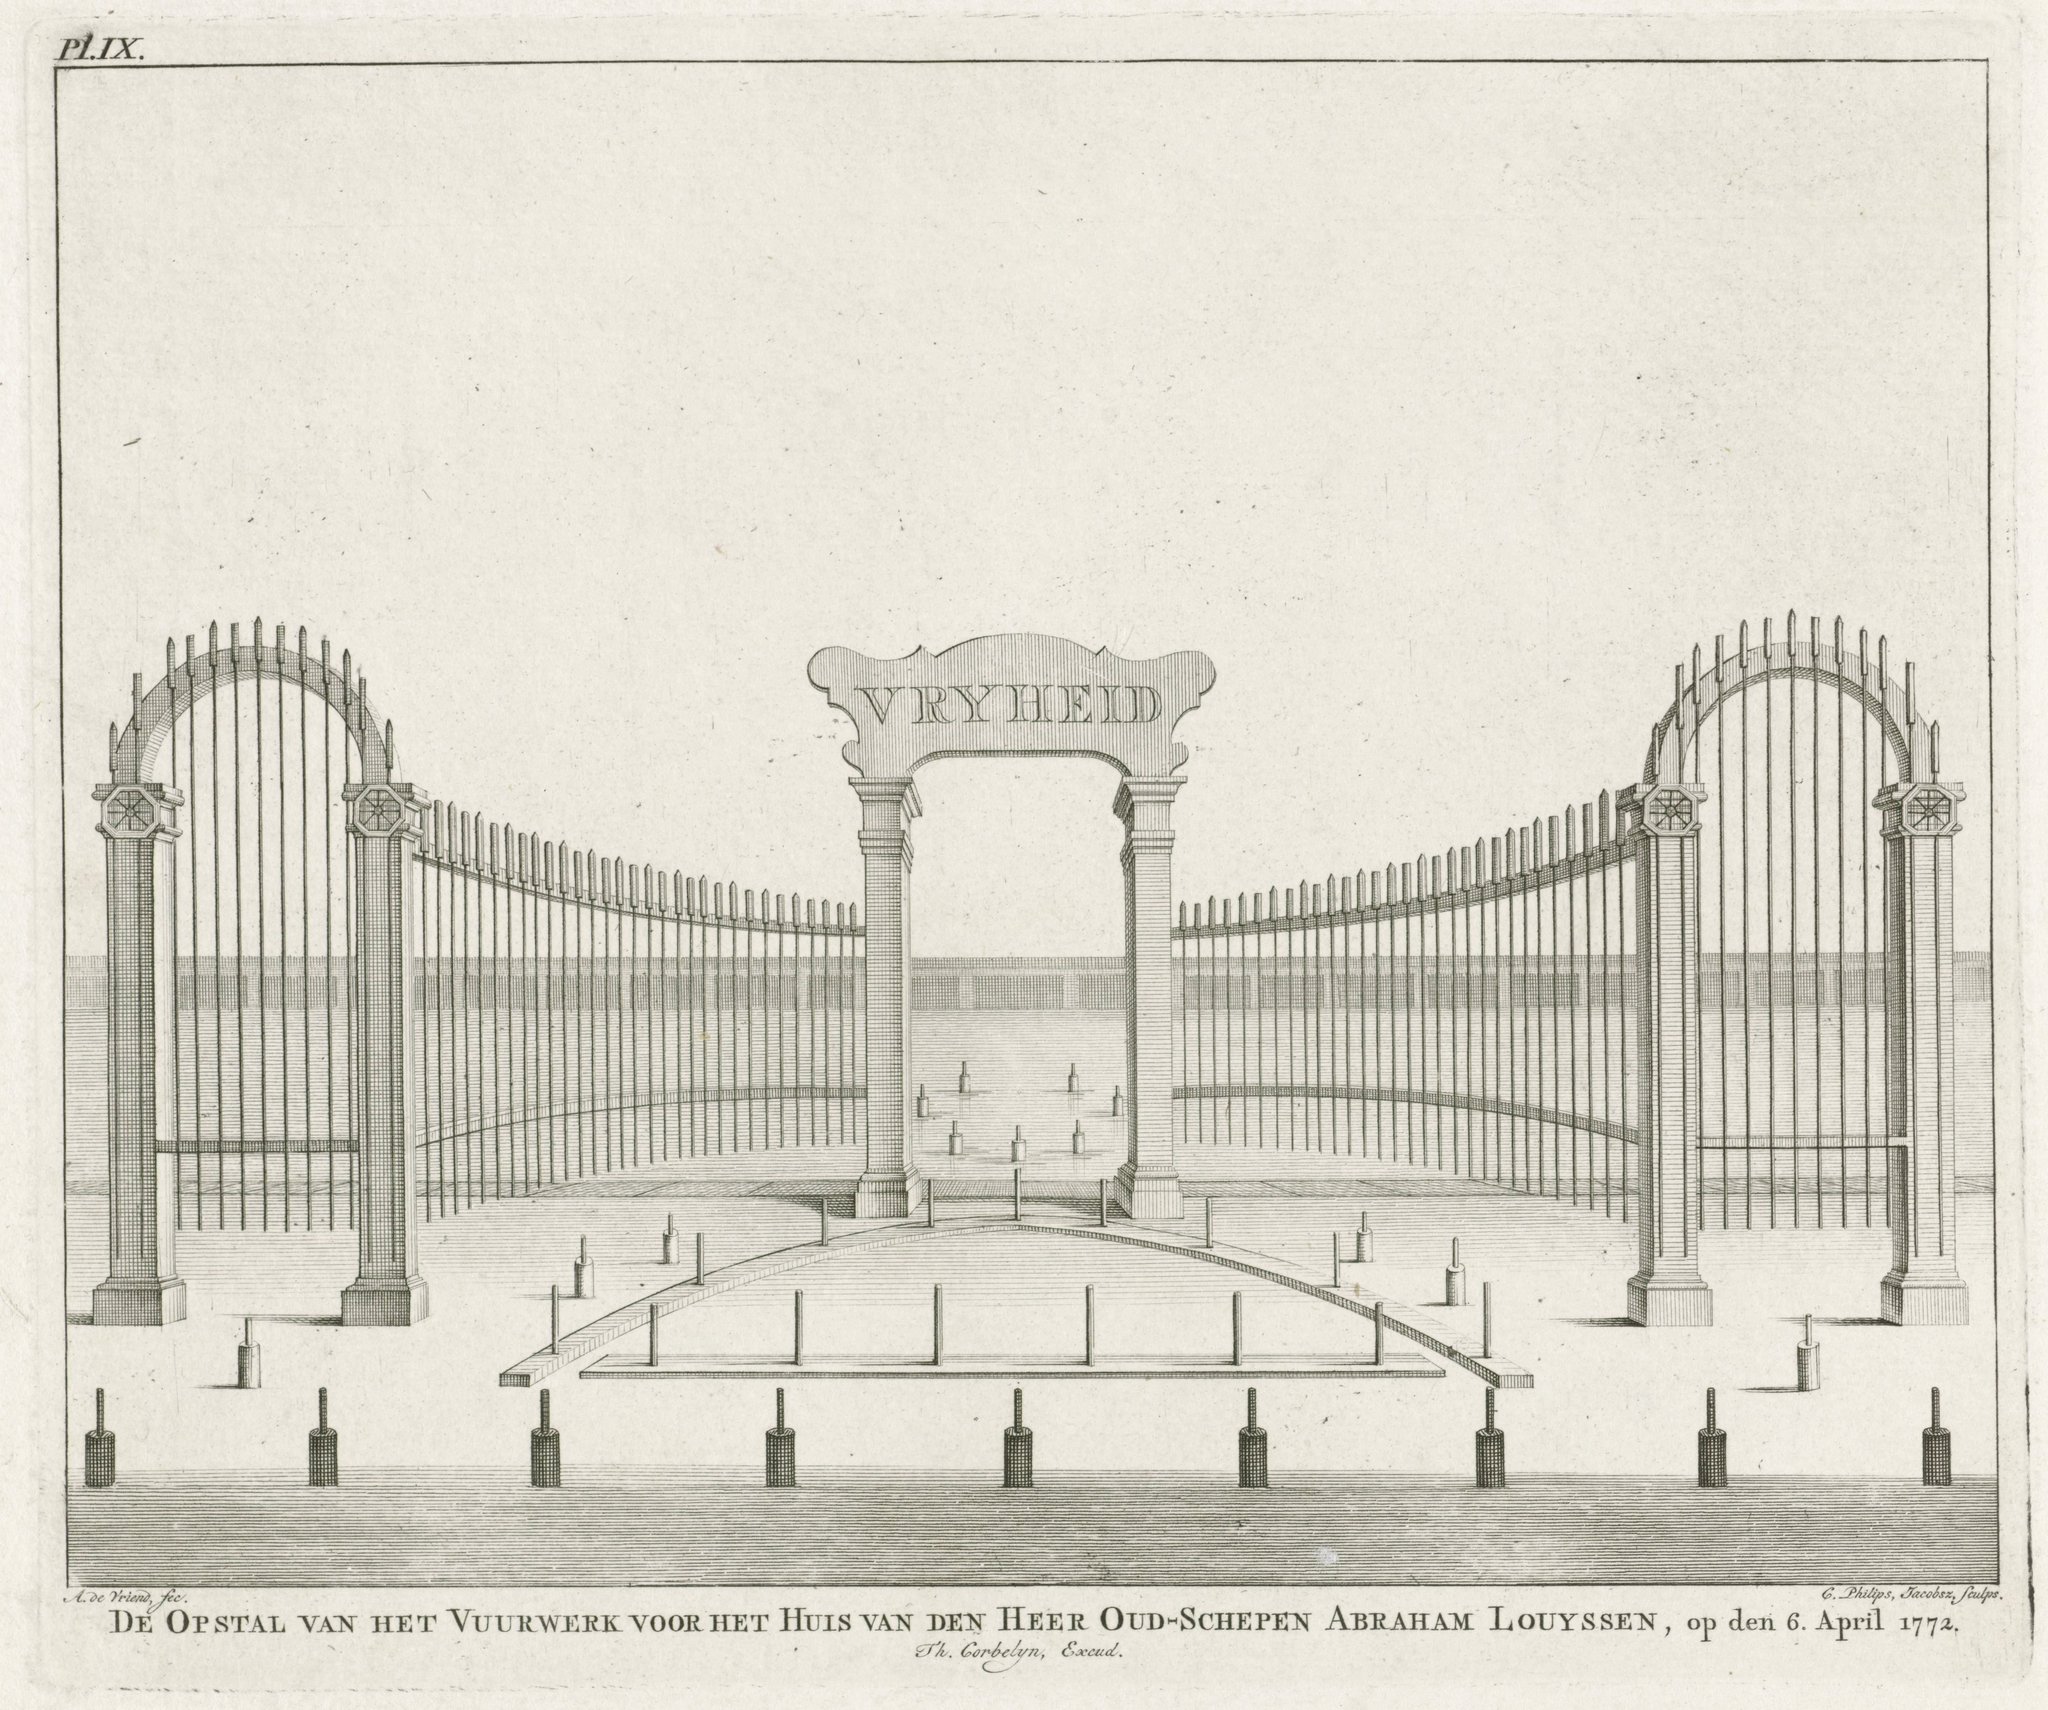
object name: print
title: De Opstal van het Vuurwerk voor het Huis van den Heer Oud-Schepen Abraham Louyssen, op den 6. April 1772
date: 1772-1773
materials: paper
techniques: engraving, etching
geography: northern netherlands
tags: rejoicing on special occasions (+ illumination, fire-works ~ festive activities), flushing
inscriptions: collector's mark: Lugt 2228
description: Stellage voor het vuurwerk te Vlissingen opgesteld voor het huis van oudschepen Abraham Louyssen, bij de viering van 200 jaar vrijheid in Vlissingen, 6 april 1772. Op een erepoort het opschrift: Vryheid. Genummerd linksboven: Pl. IX. Onderdeel van een groep van negen platen genummerd I-X van de decoraties bij dit feest.